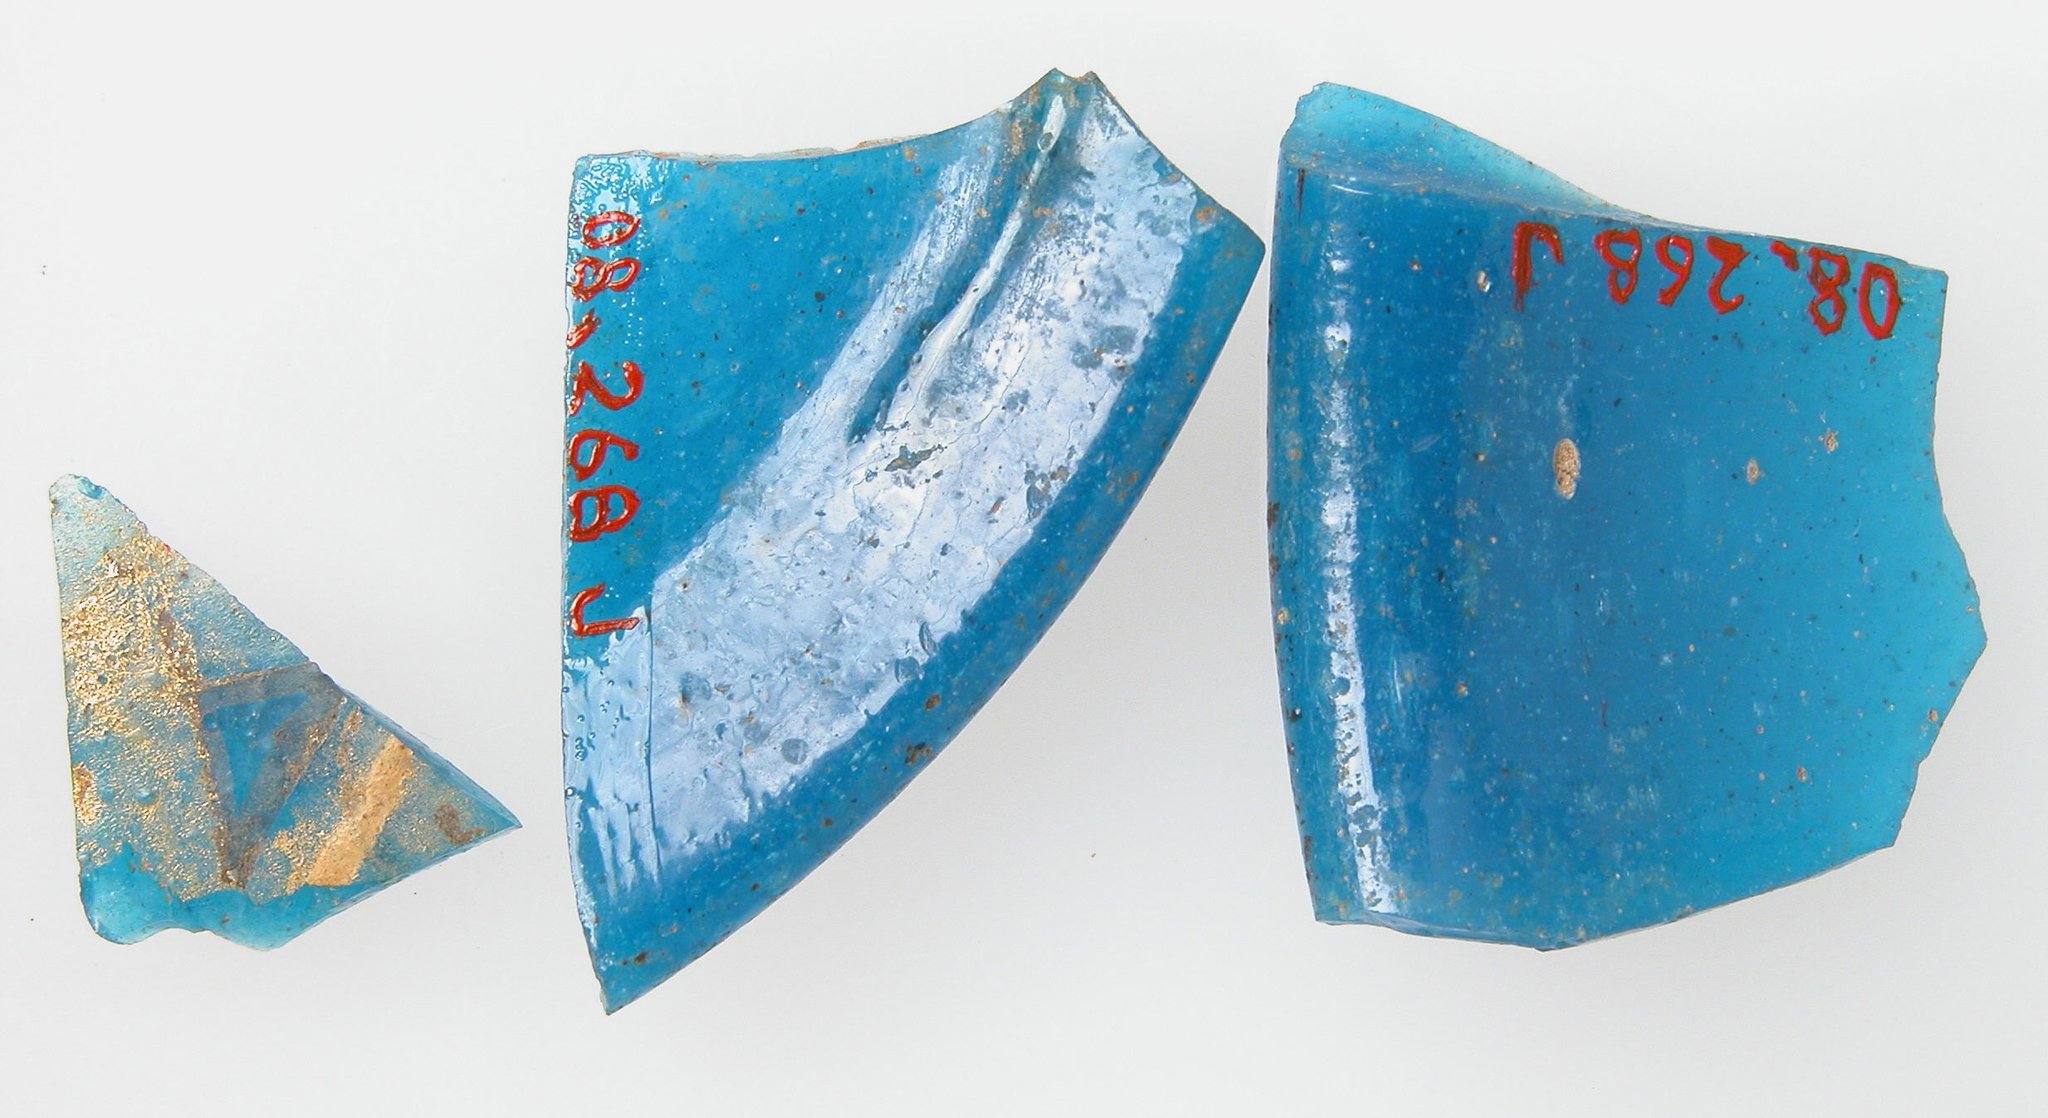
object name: fragment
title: Glass Fragments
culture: coptic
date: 301-433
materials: glass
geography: egypt